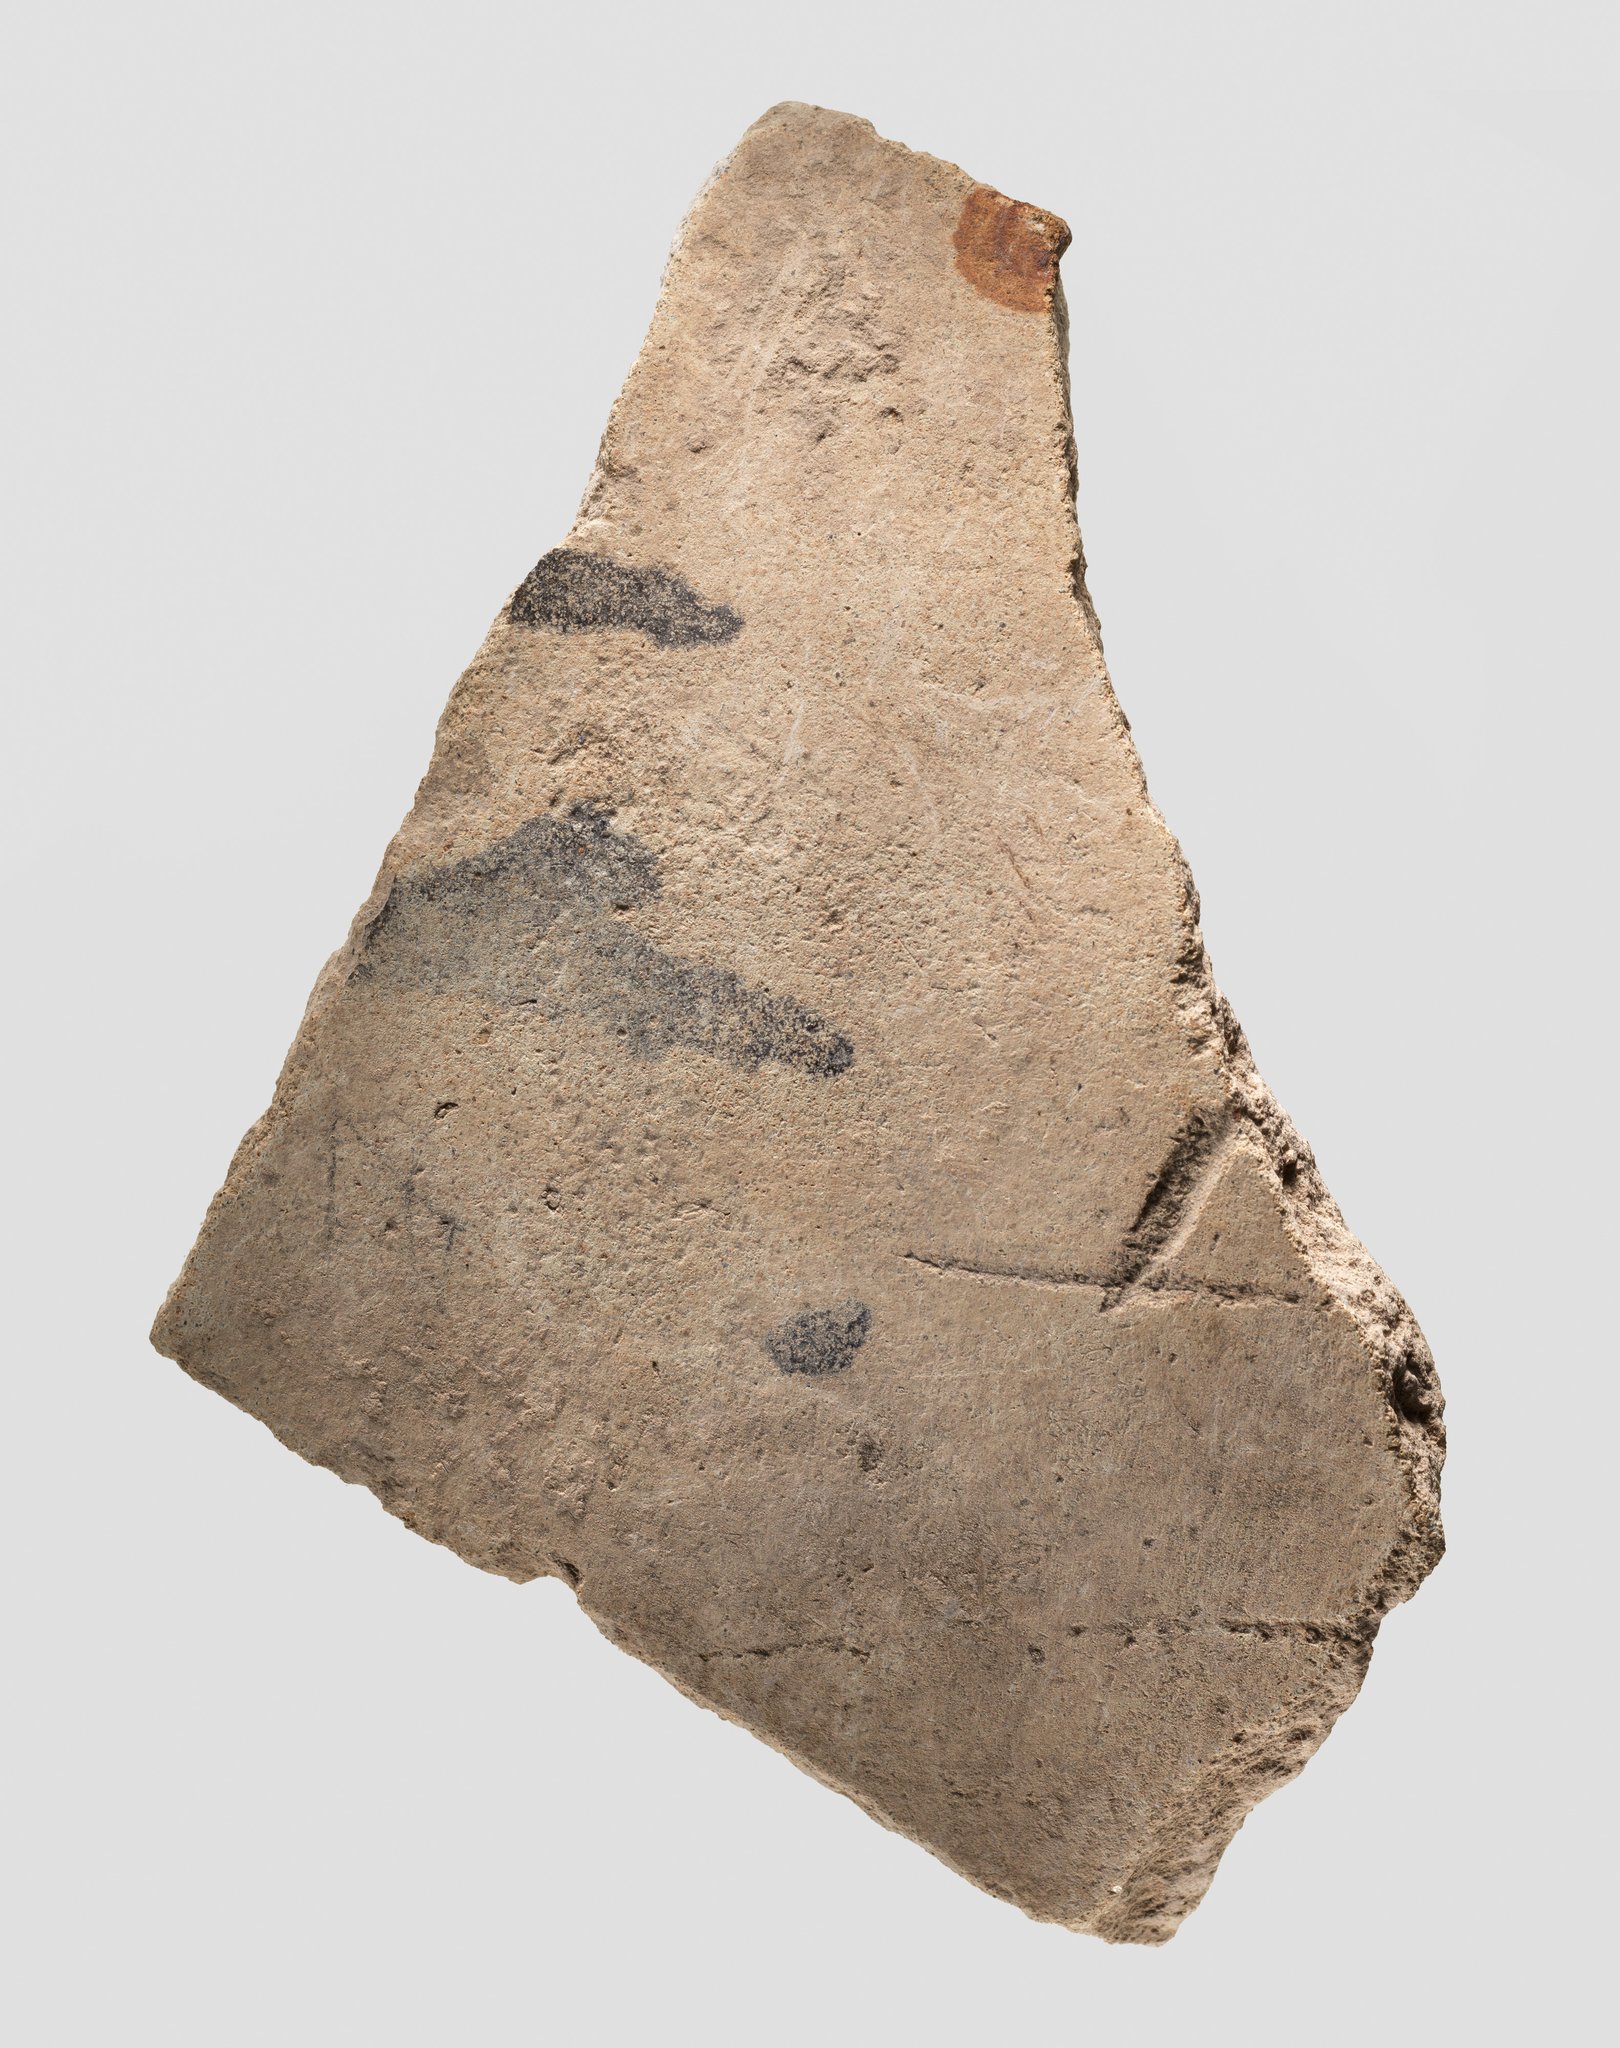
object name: sherd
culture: sasanian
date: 201-700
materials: ceramic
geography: mesopotamia